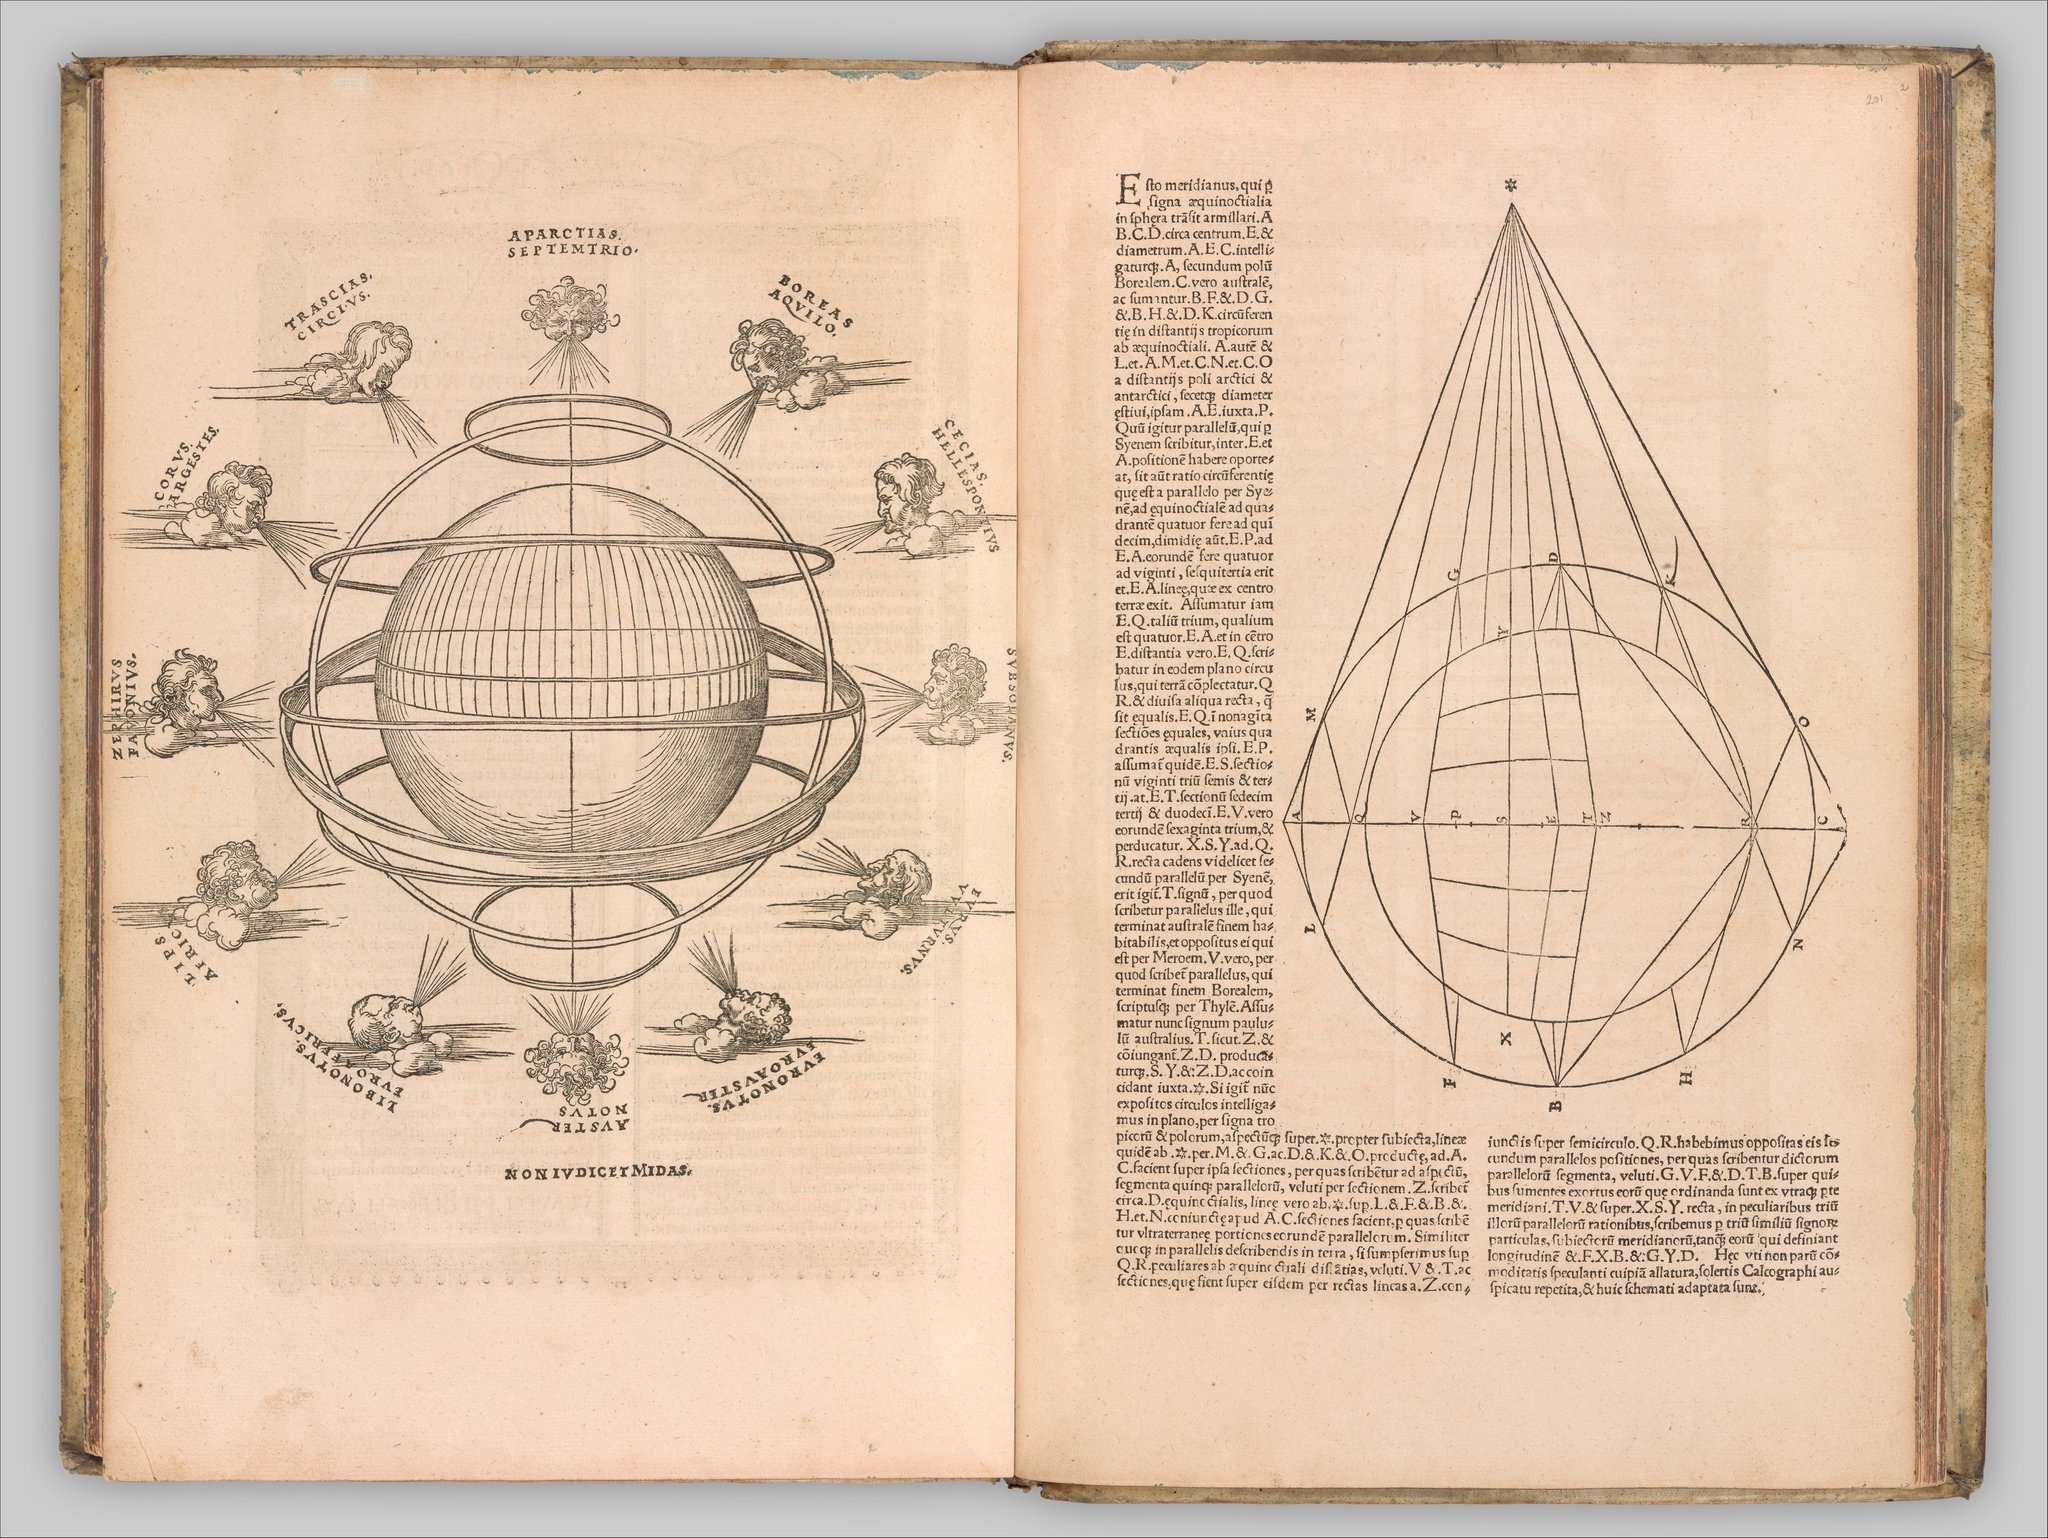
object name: book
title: In Claudii Ptolemaei Geographiacae Enarrationis Libri octo.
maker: claudius ptolemaeus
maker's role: author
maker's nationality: greek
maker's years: 95-175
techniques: woodcut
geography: france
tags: science,maps